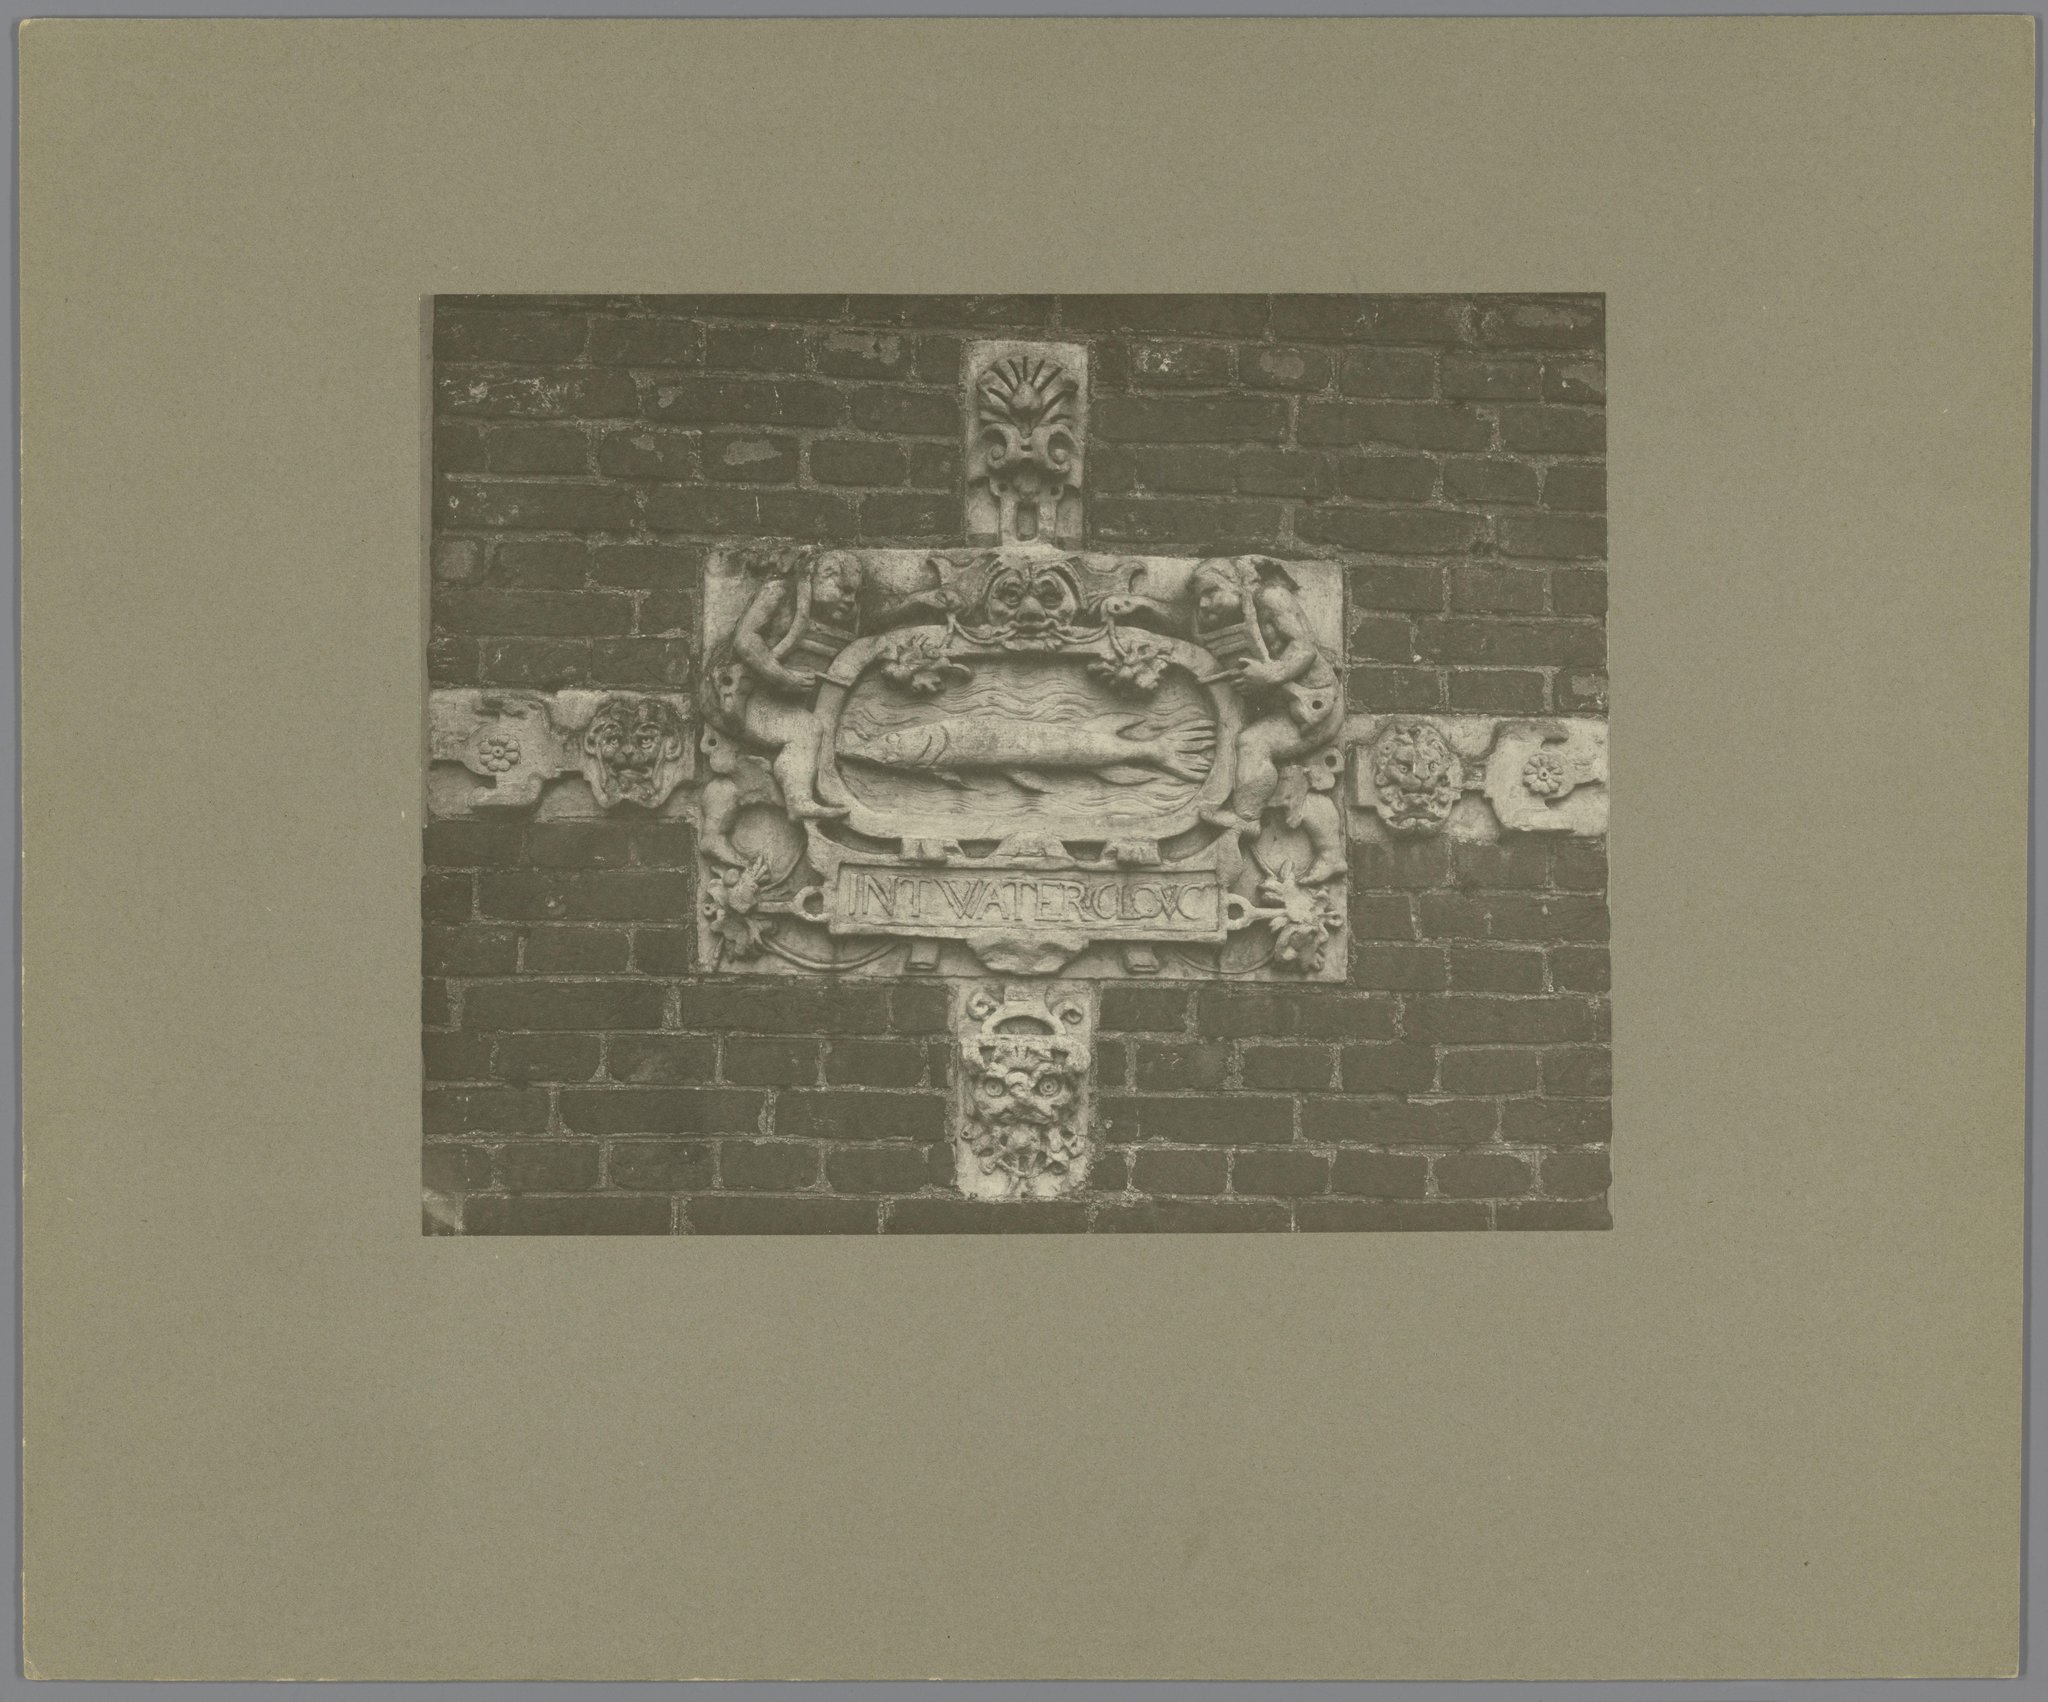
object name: photograph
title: Reliëf van kasteel Schelluinderberg te Schelluinen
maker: Anonymous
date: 1900-1930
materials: cardboard, photographic support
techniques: gelatin silver print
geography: schelluinen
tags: sculpture (+ relief ~ sculpture)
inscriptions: annotation: ‘Schelluinen Z.H./ Erven J. Veth 1972’